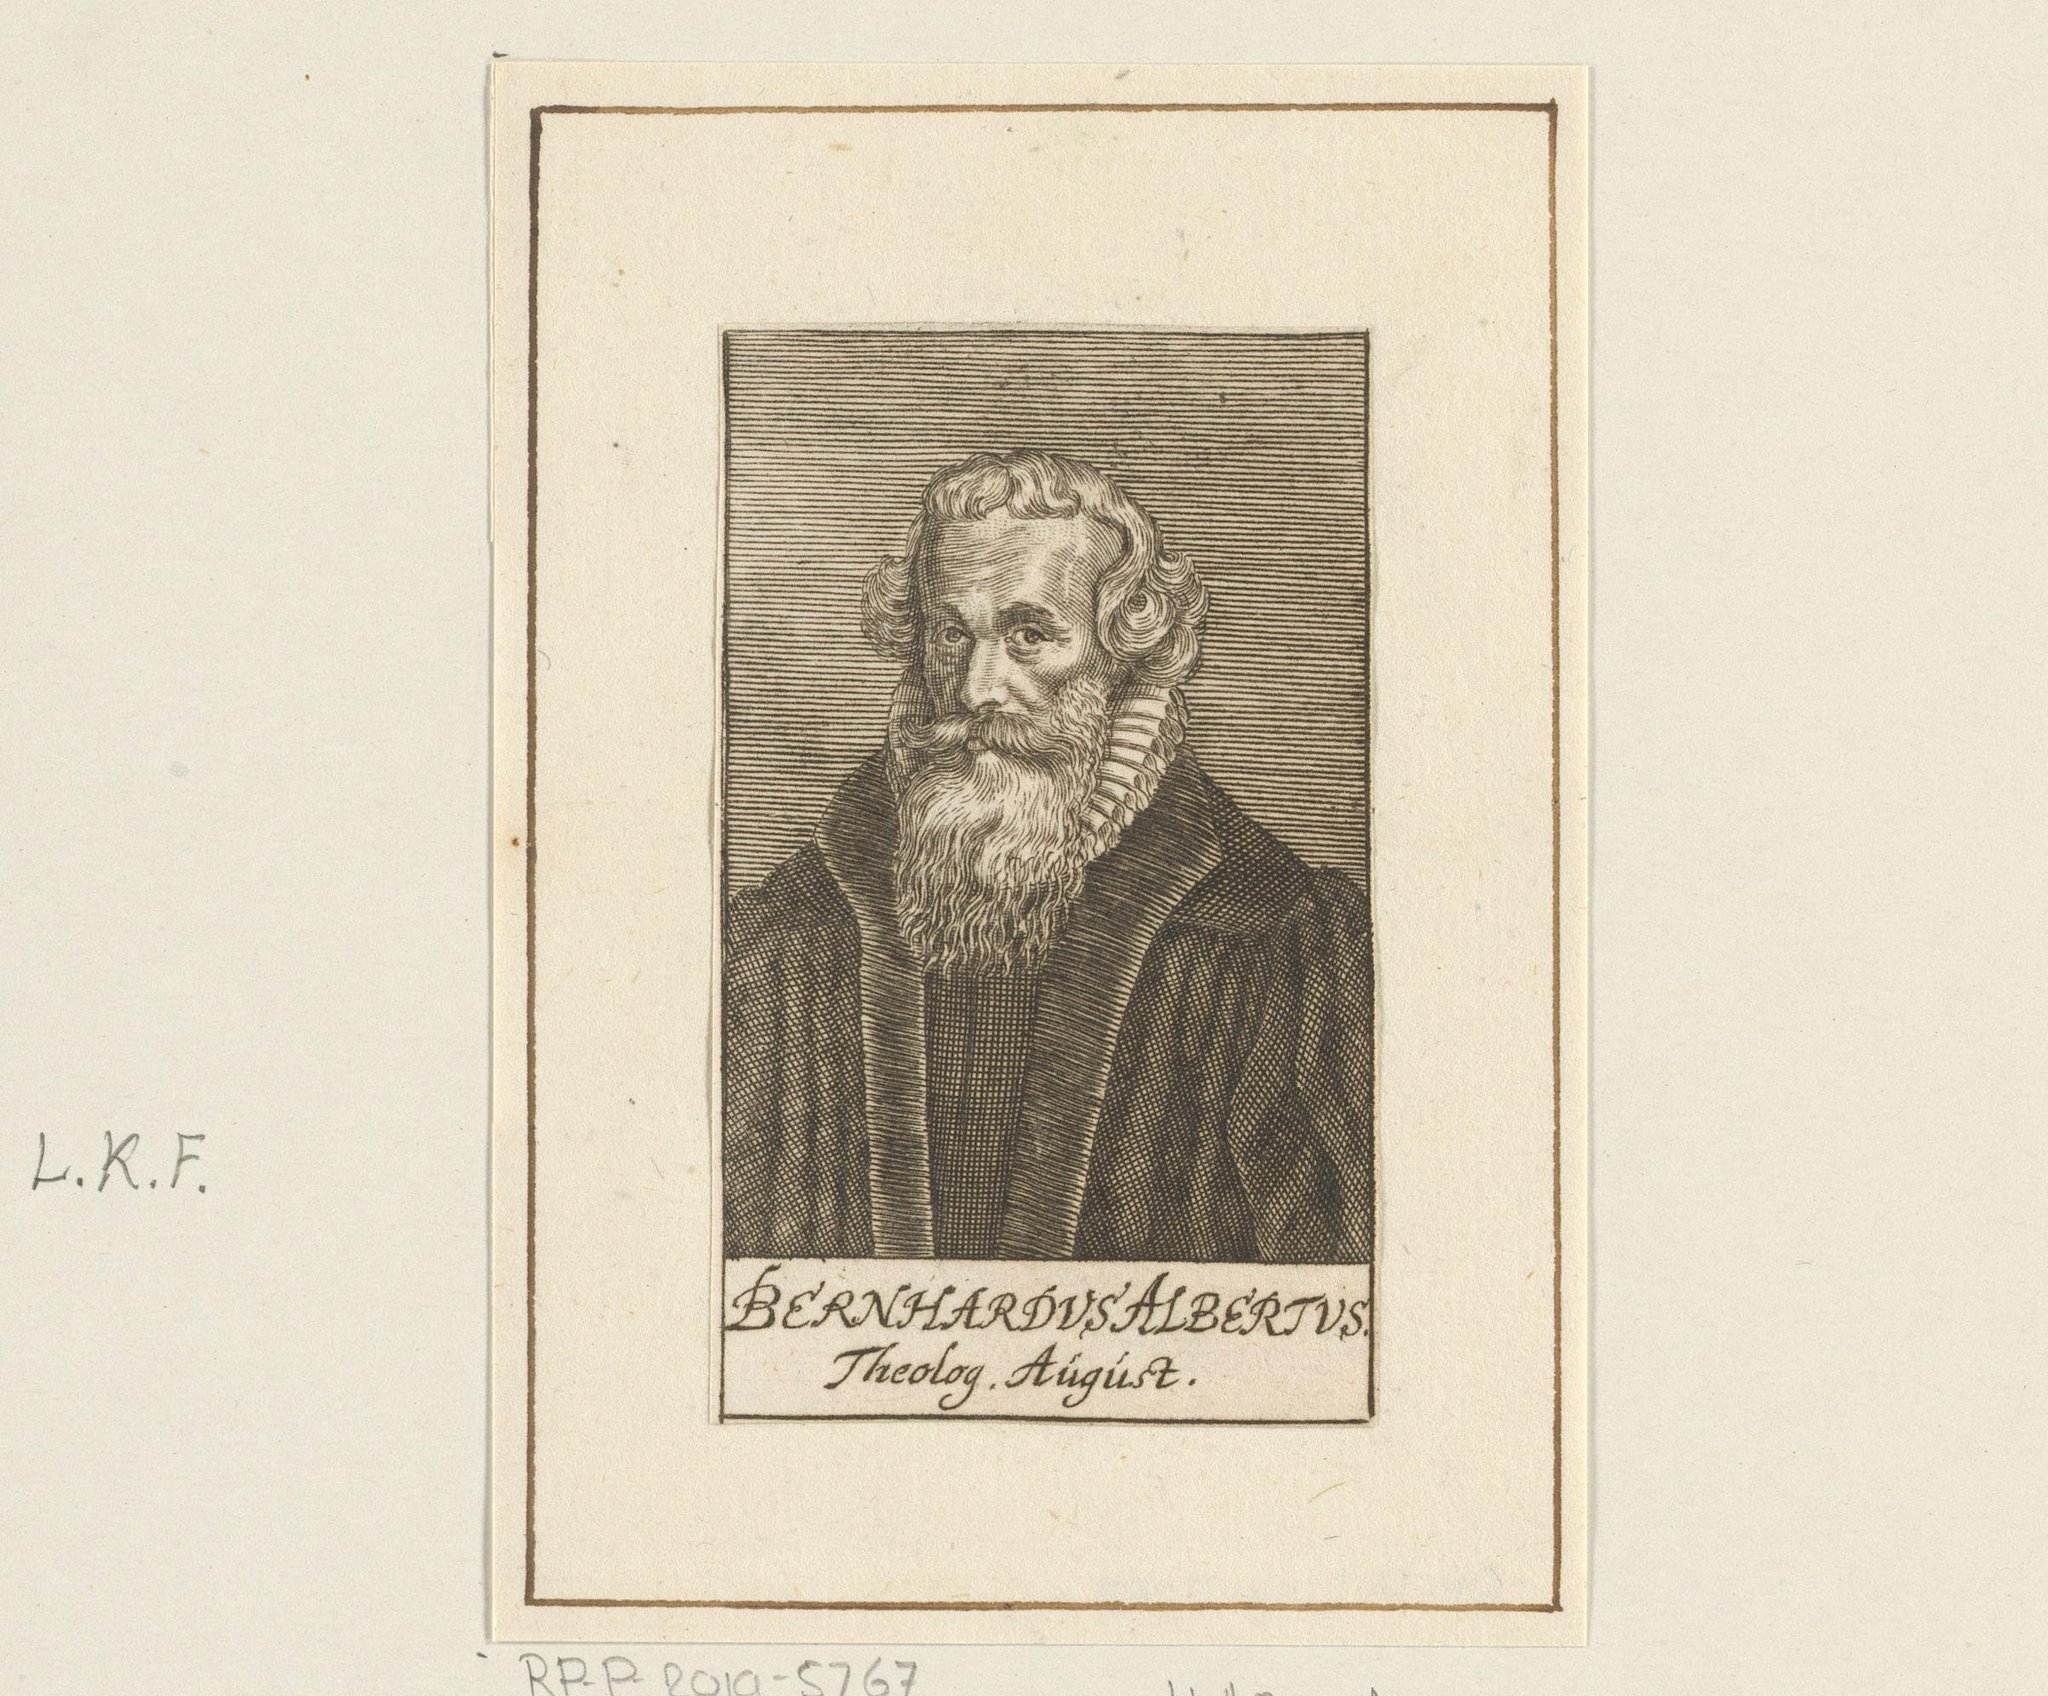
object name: print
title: Bernardus Albertus, theolog Aúgúst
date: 1688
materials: paper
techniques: engraving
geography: nuremberg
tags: theologian, historical persons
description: Prent uit: Freher, Paul. Theatrum virorum eruditione clarorum. Neurenberg: Johann Hoffmann, 1688.